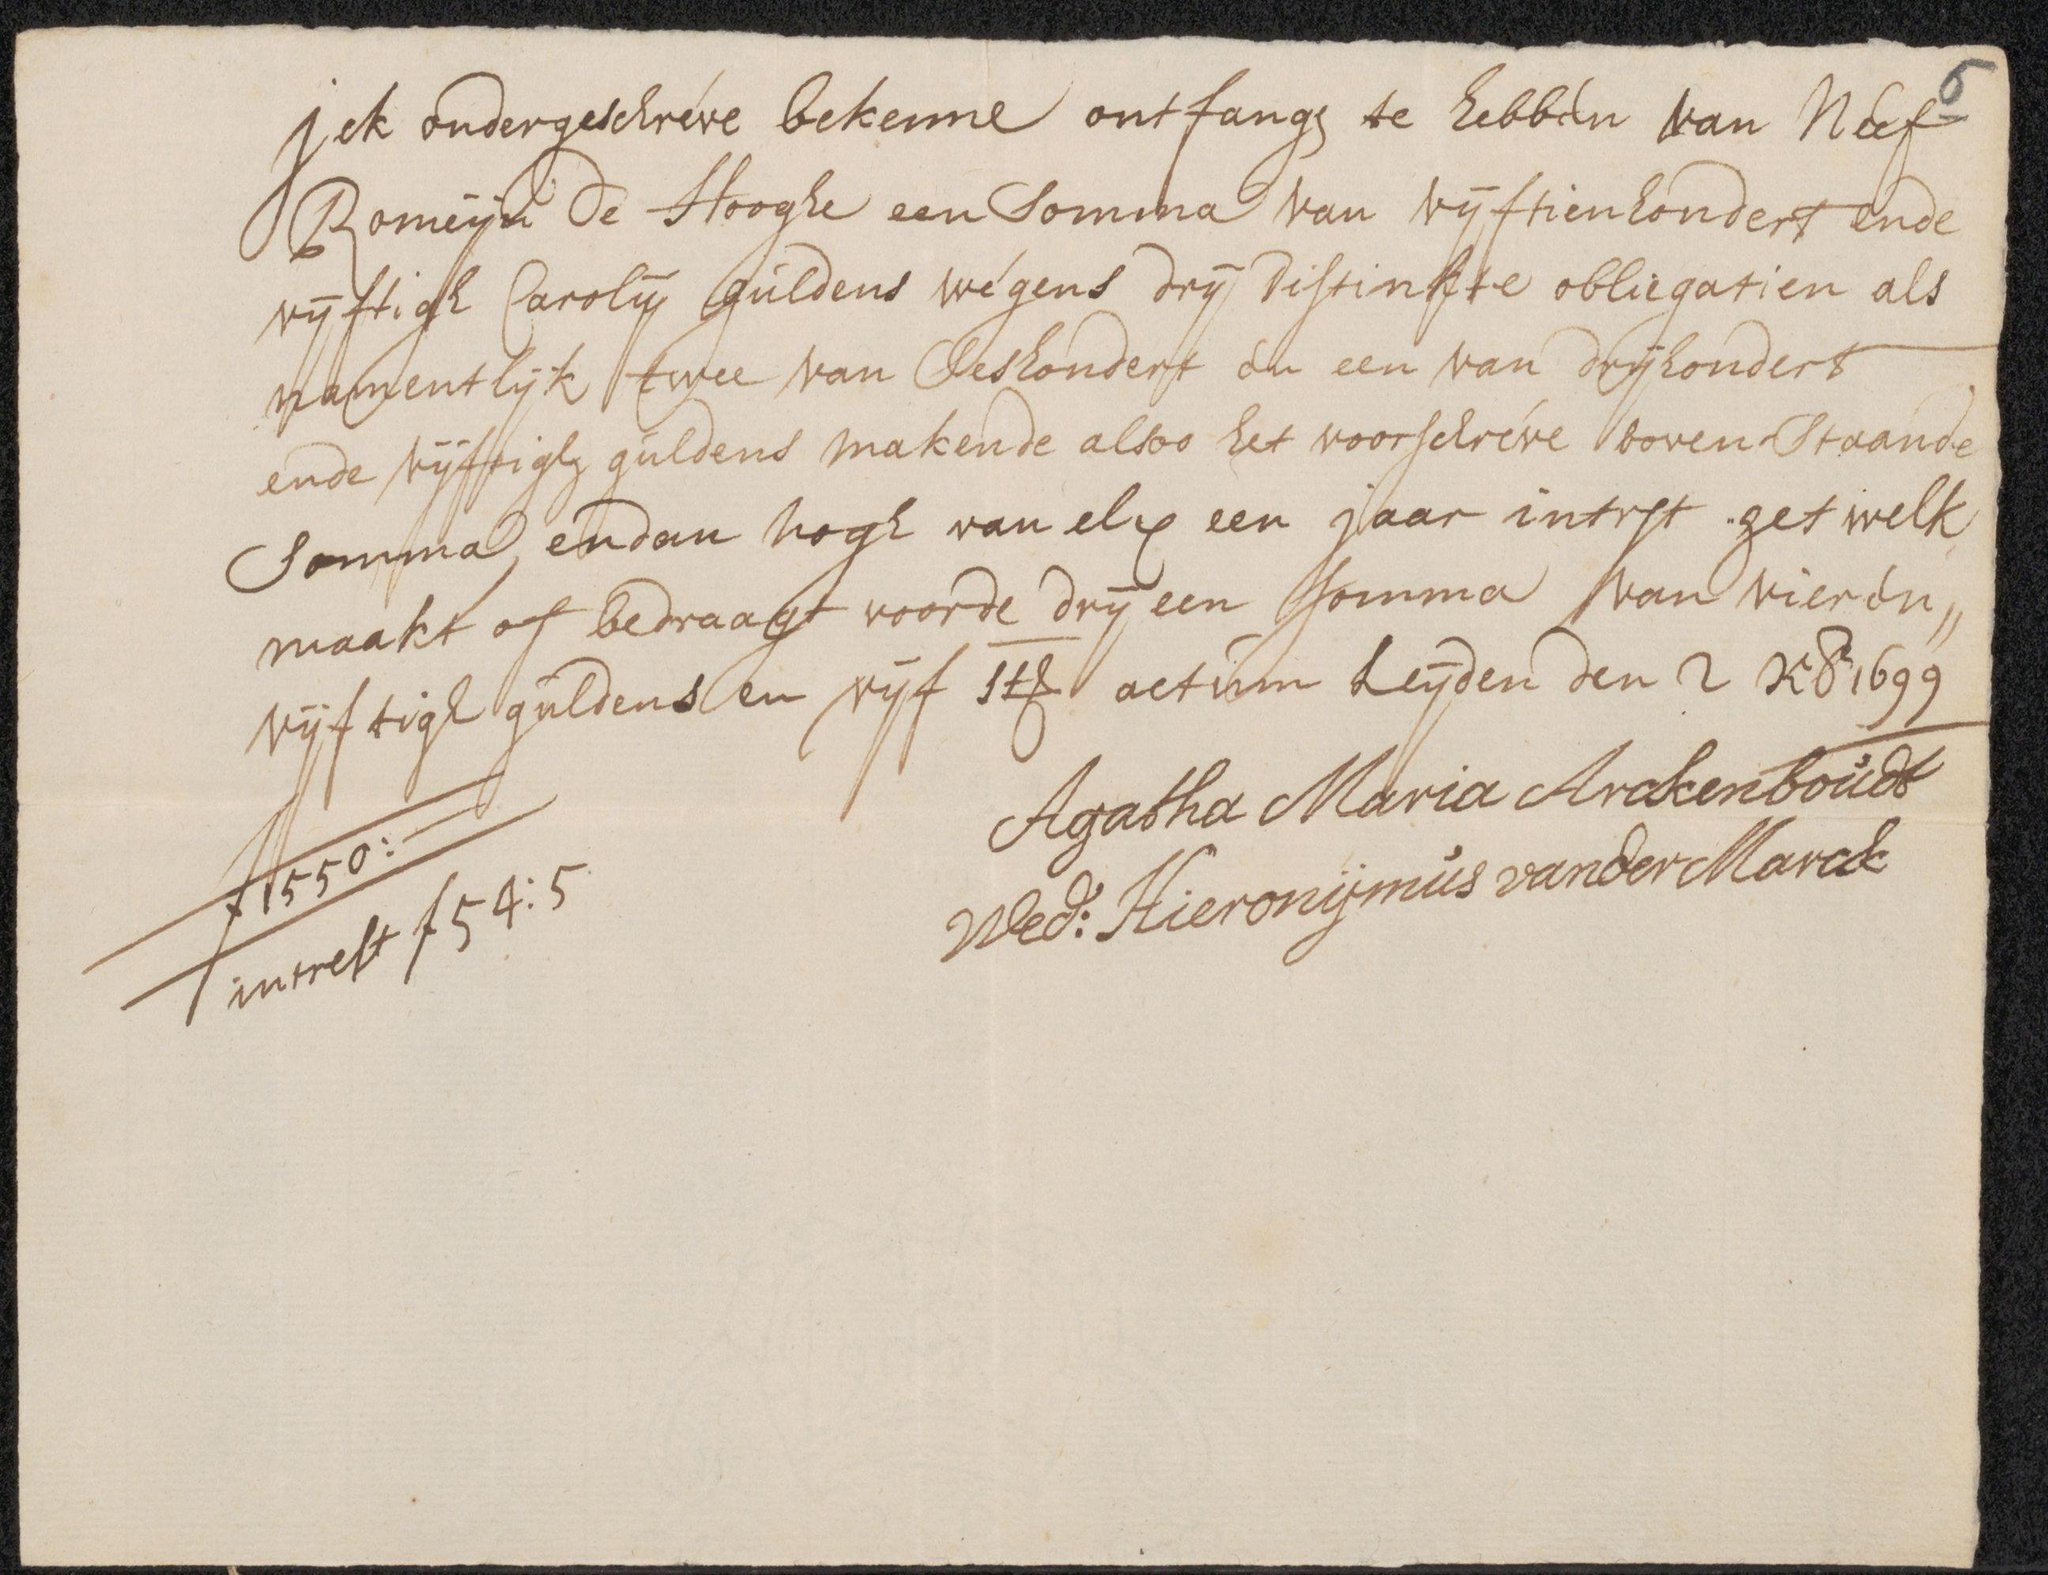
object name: ontvangstbewijs, kwitantie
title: Kwitantie voor Romeyn de Hooghe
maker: agatha maria arkenbout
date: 1699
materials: ink, paper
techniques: pen, writing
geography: leiden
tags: amsterdam, painter, print maker, draughtsman, goldsmith, romeyn de hooghe, money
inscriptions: collector's mark: Lugt 2233, watermark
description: Betreft vermoedelijk een kwitantie voor de kunstenaar Romeyn de Hooghe (1645-1708), Romeyn de Hooghe (1638-1710) of Romeyn de Hooghe (1655-1704).